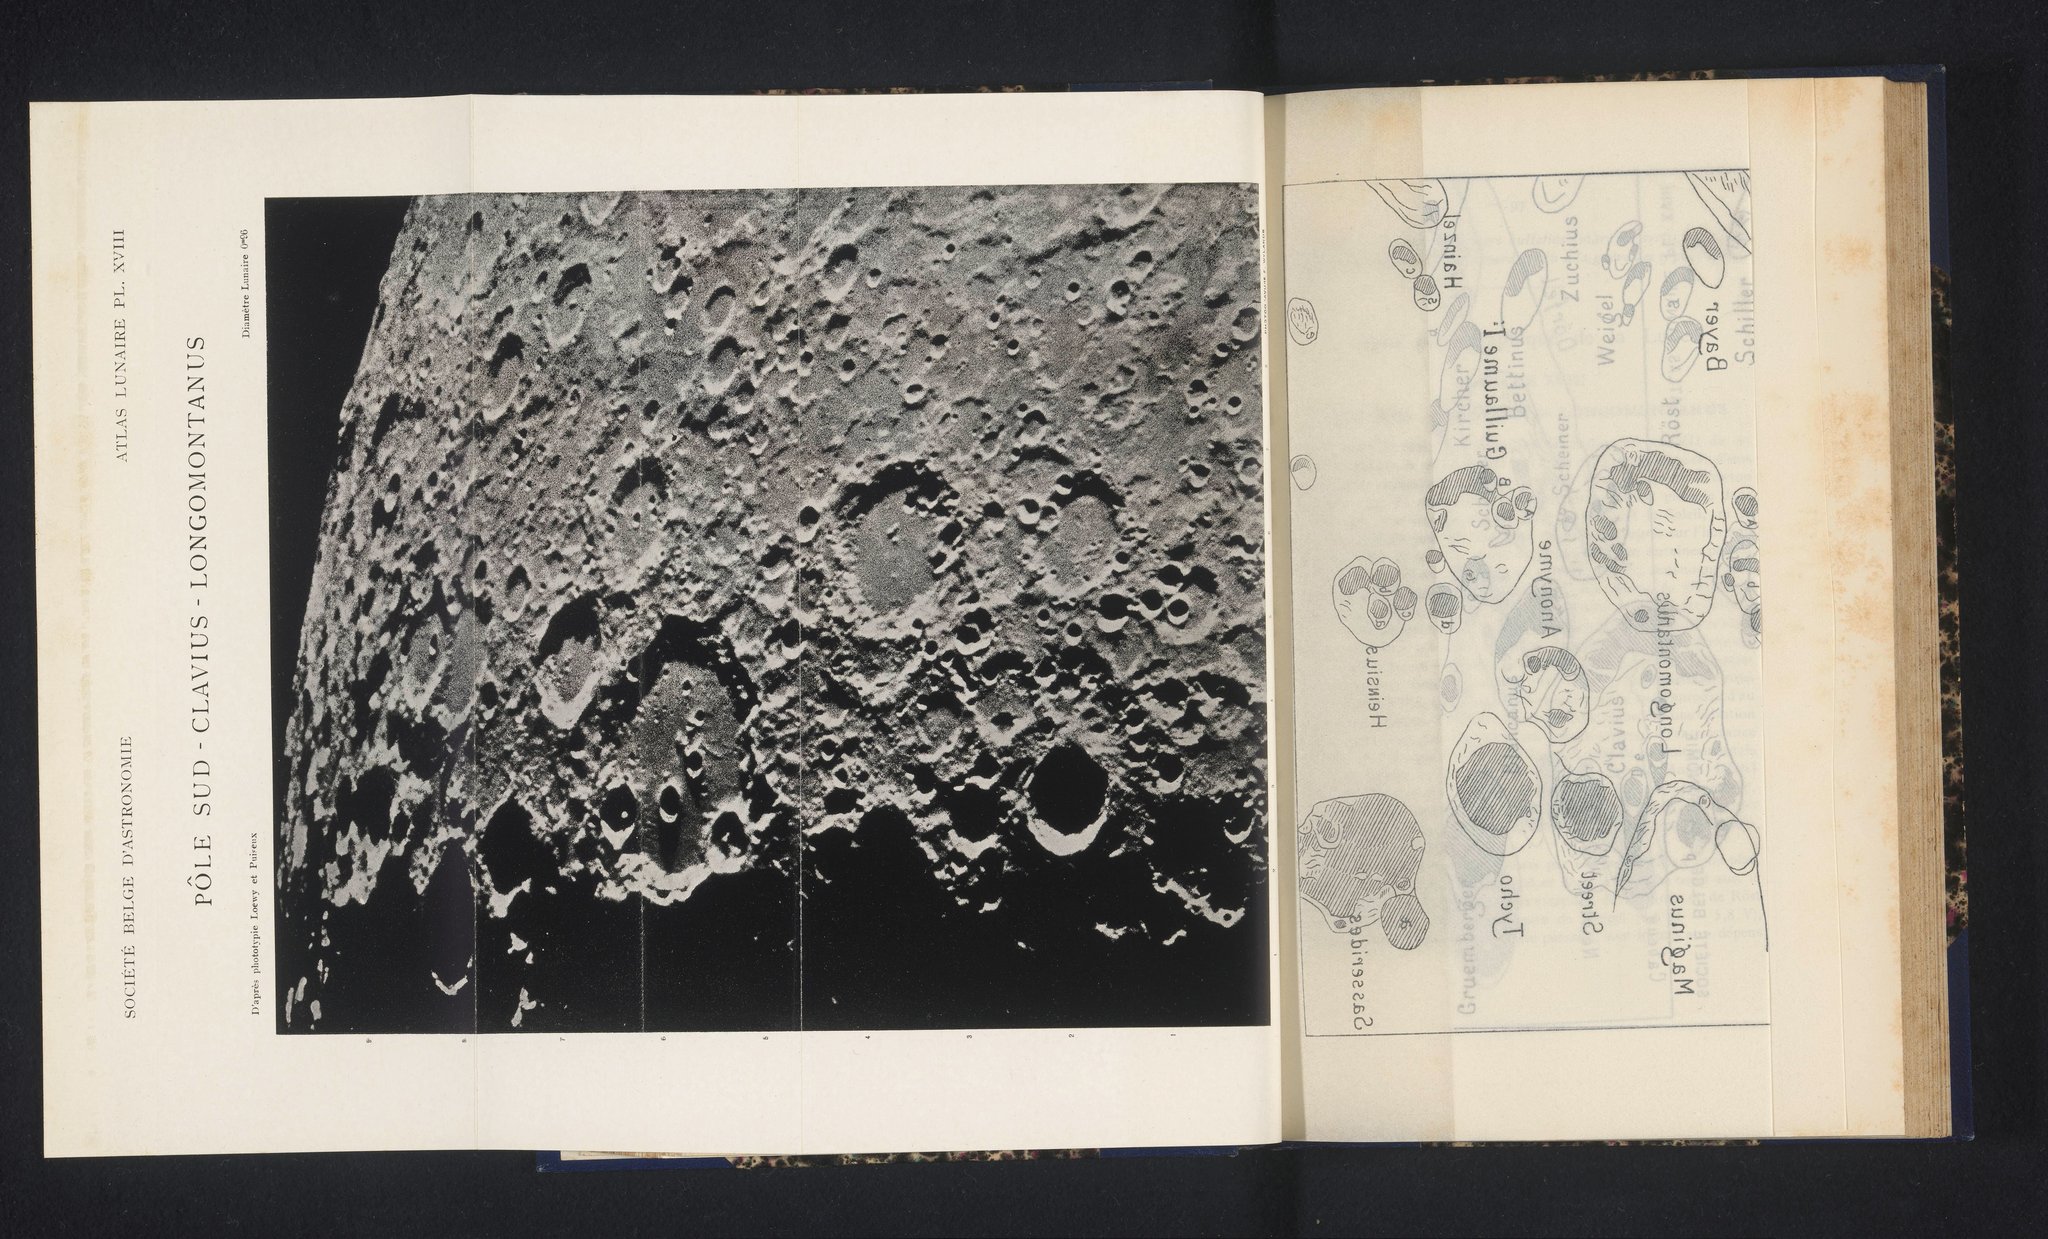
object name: photomechanical print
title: Kraters op de maan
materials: paper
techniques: autotype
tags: surface of the moon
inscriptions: inscription: ‘Société Belge D'Astronomie Atlas Lunaire Pl. XVIII/ 1896, Septembre 29, 16 h. 0m. (T. M. de Paris)’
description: Transparante pagina voor prent als kaart met daarop de namen van de verschillende kraters.